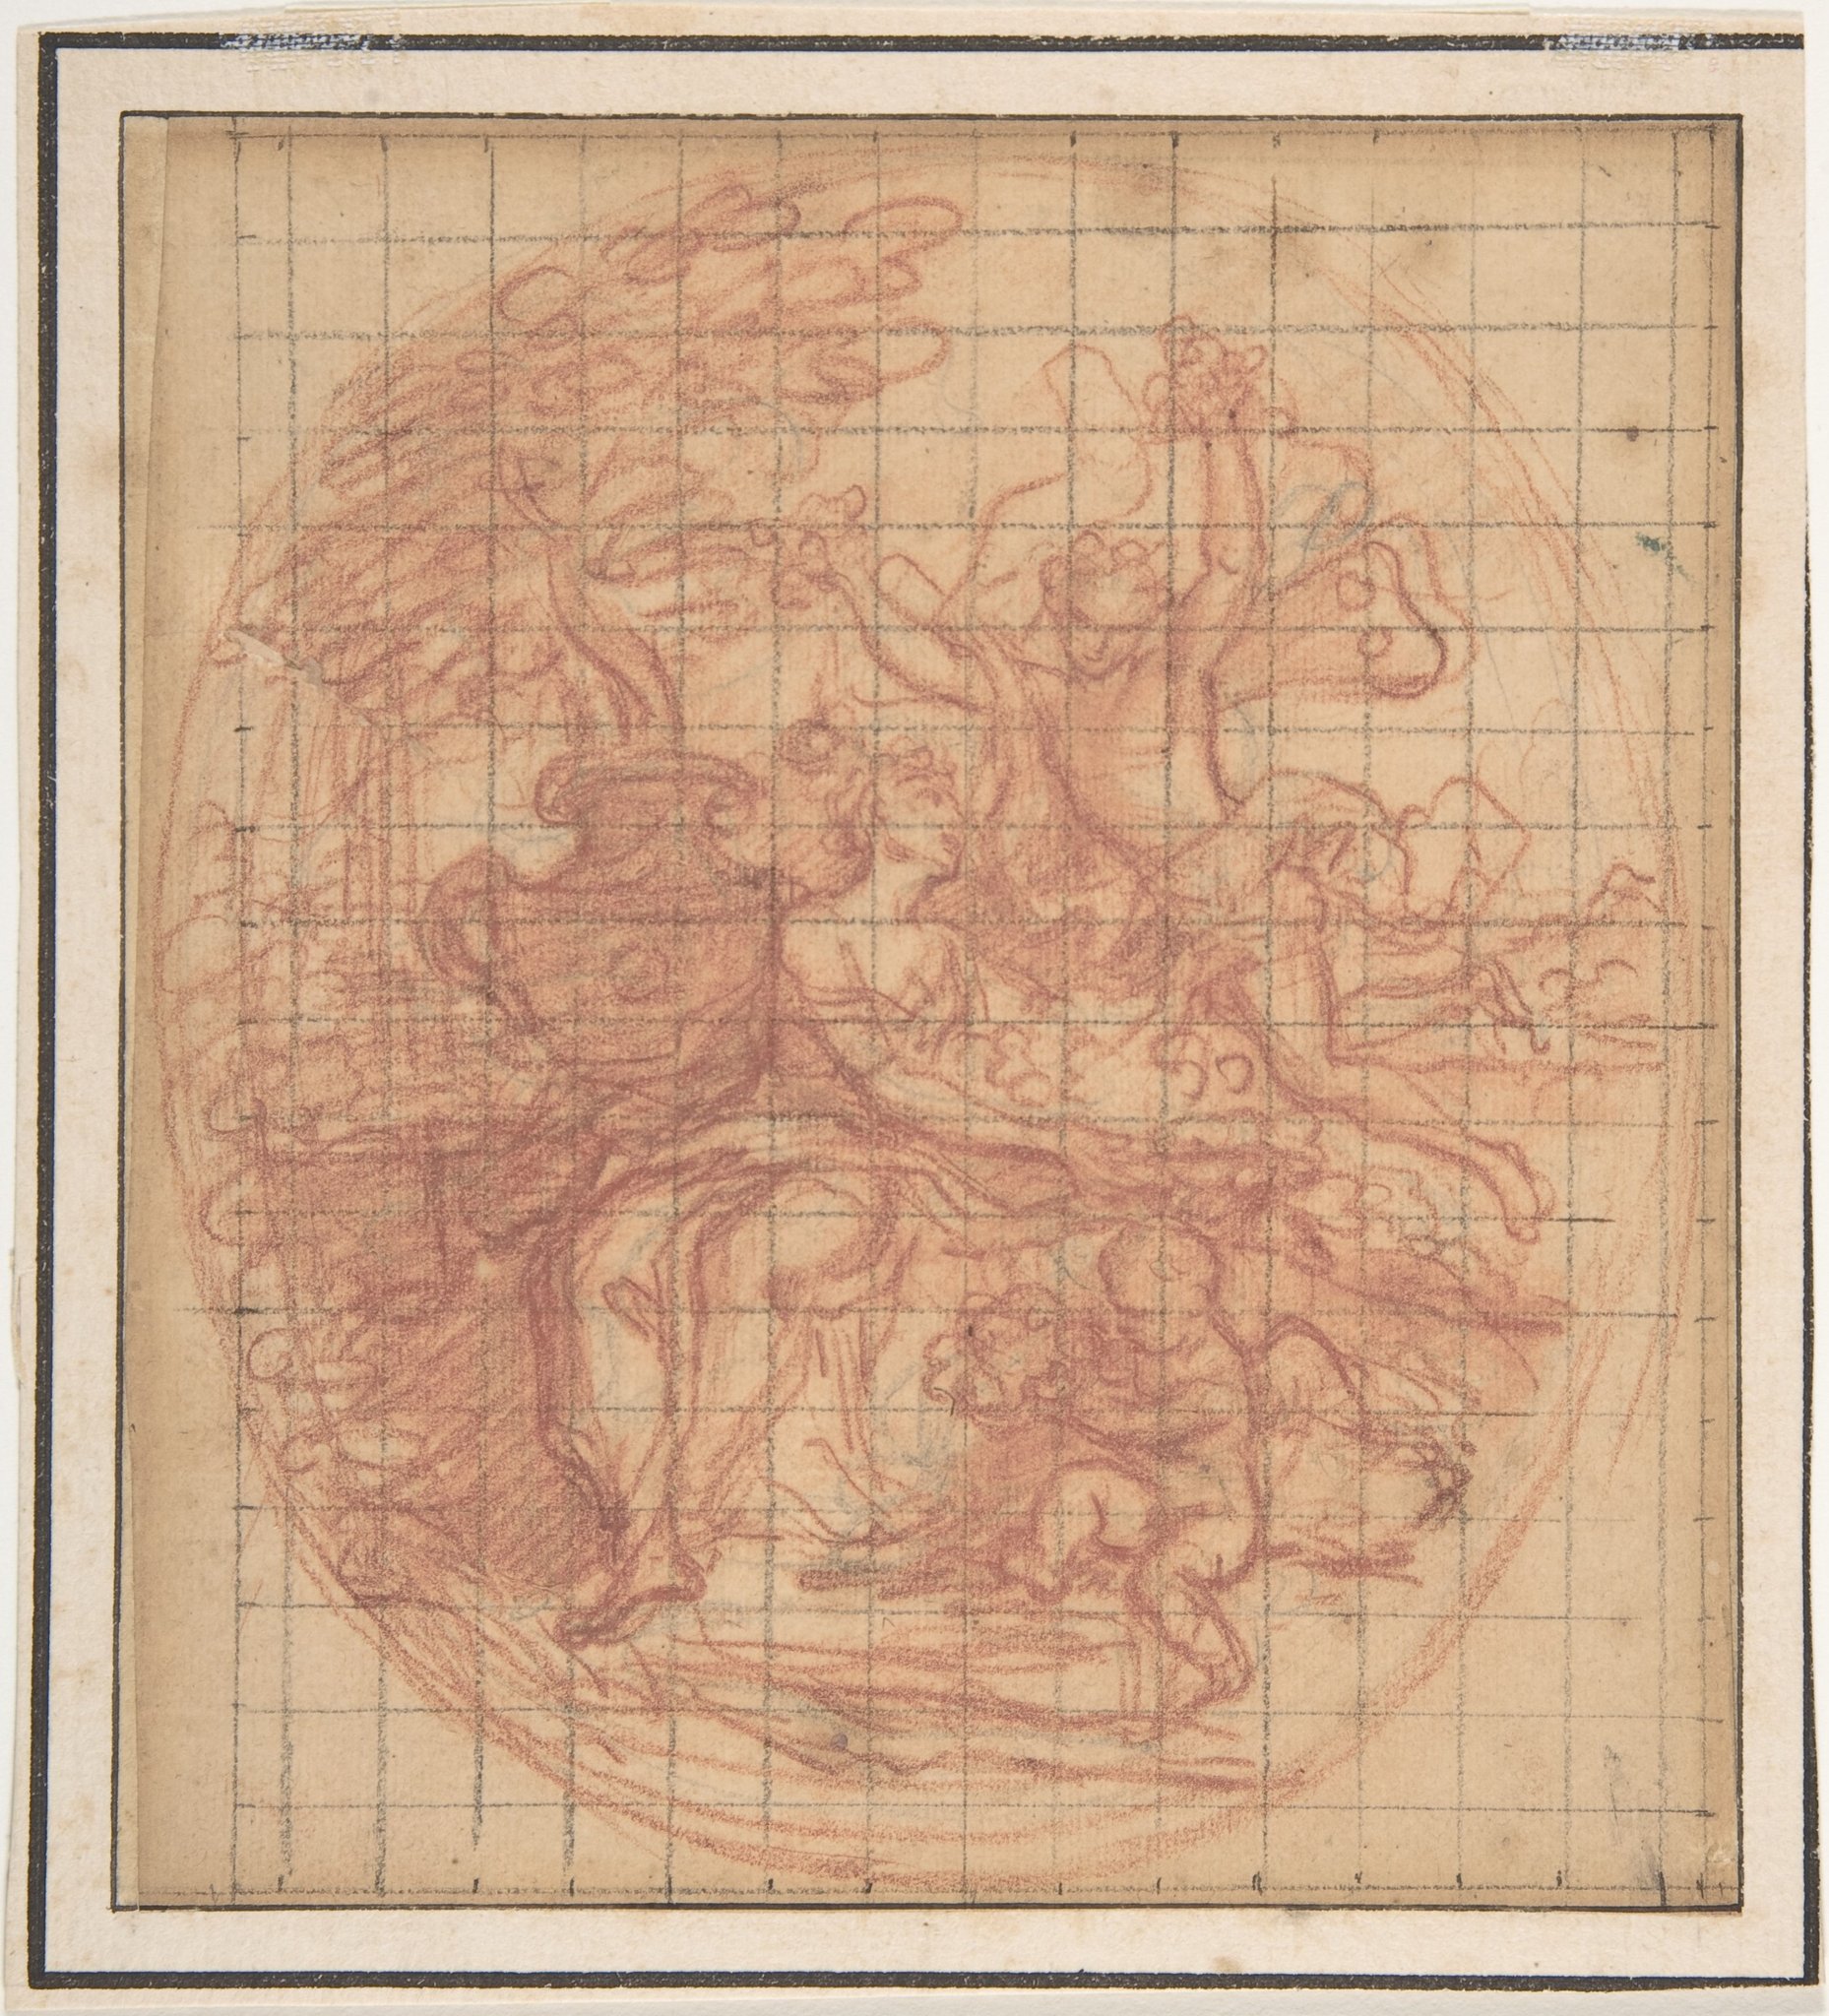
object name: drawing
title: Zephyr and Flora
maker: antoine coypel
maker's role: artist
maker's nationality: french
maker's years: 1661-1722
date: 1670-1725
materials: chalk, graphite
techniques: drawing